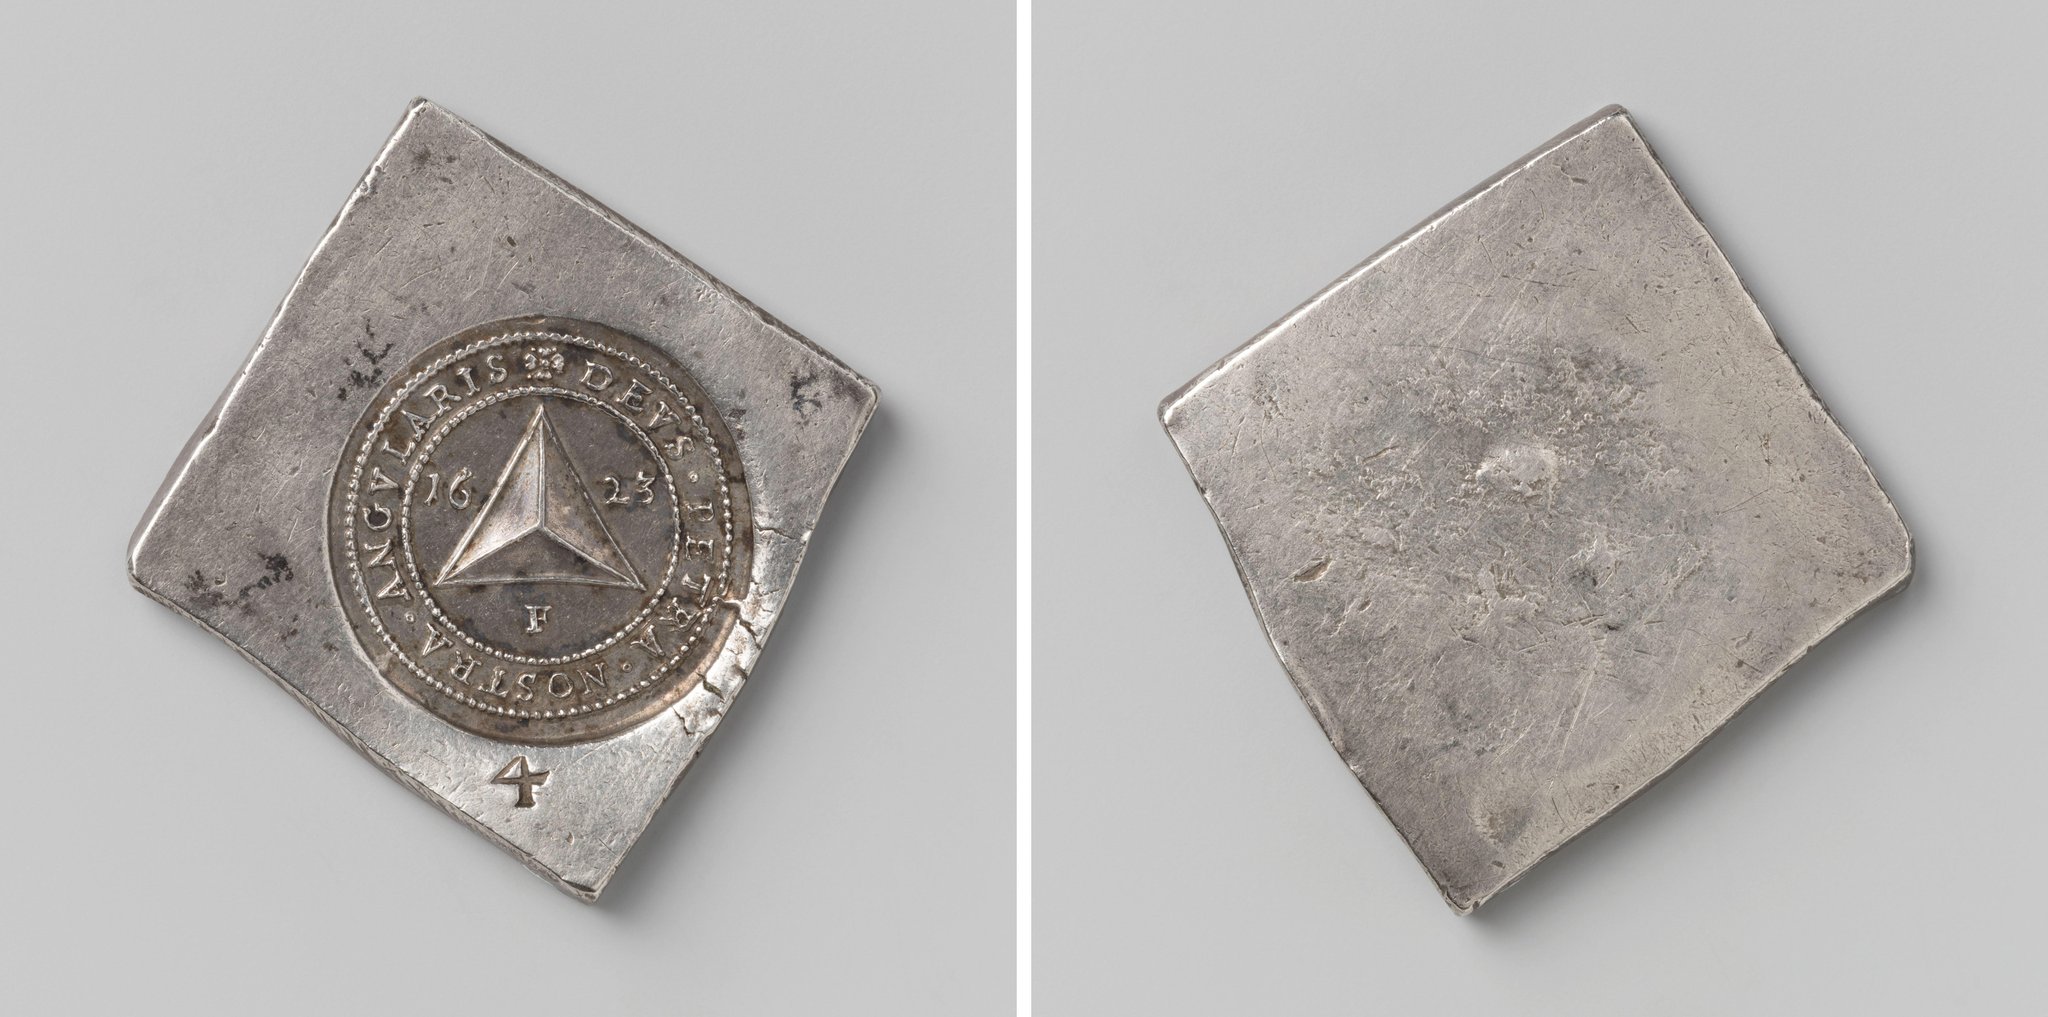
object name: taler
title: taler; vier eenheden, noodmunt uit Frankenthal, geslagen tijdens het beleg door Verdugo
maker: Anonymous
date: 1623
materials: silver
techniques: striking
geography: frankenthal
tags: bad kreuznach, generaal, wilhelm von verdugo (graaf), frankenthal, beleg van frankenthal (1623)